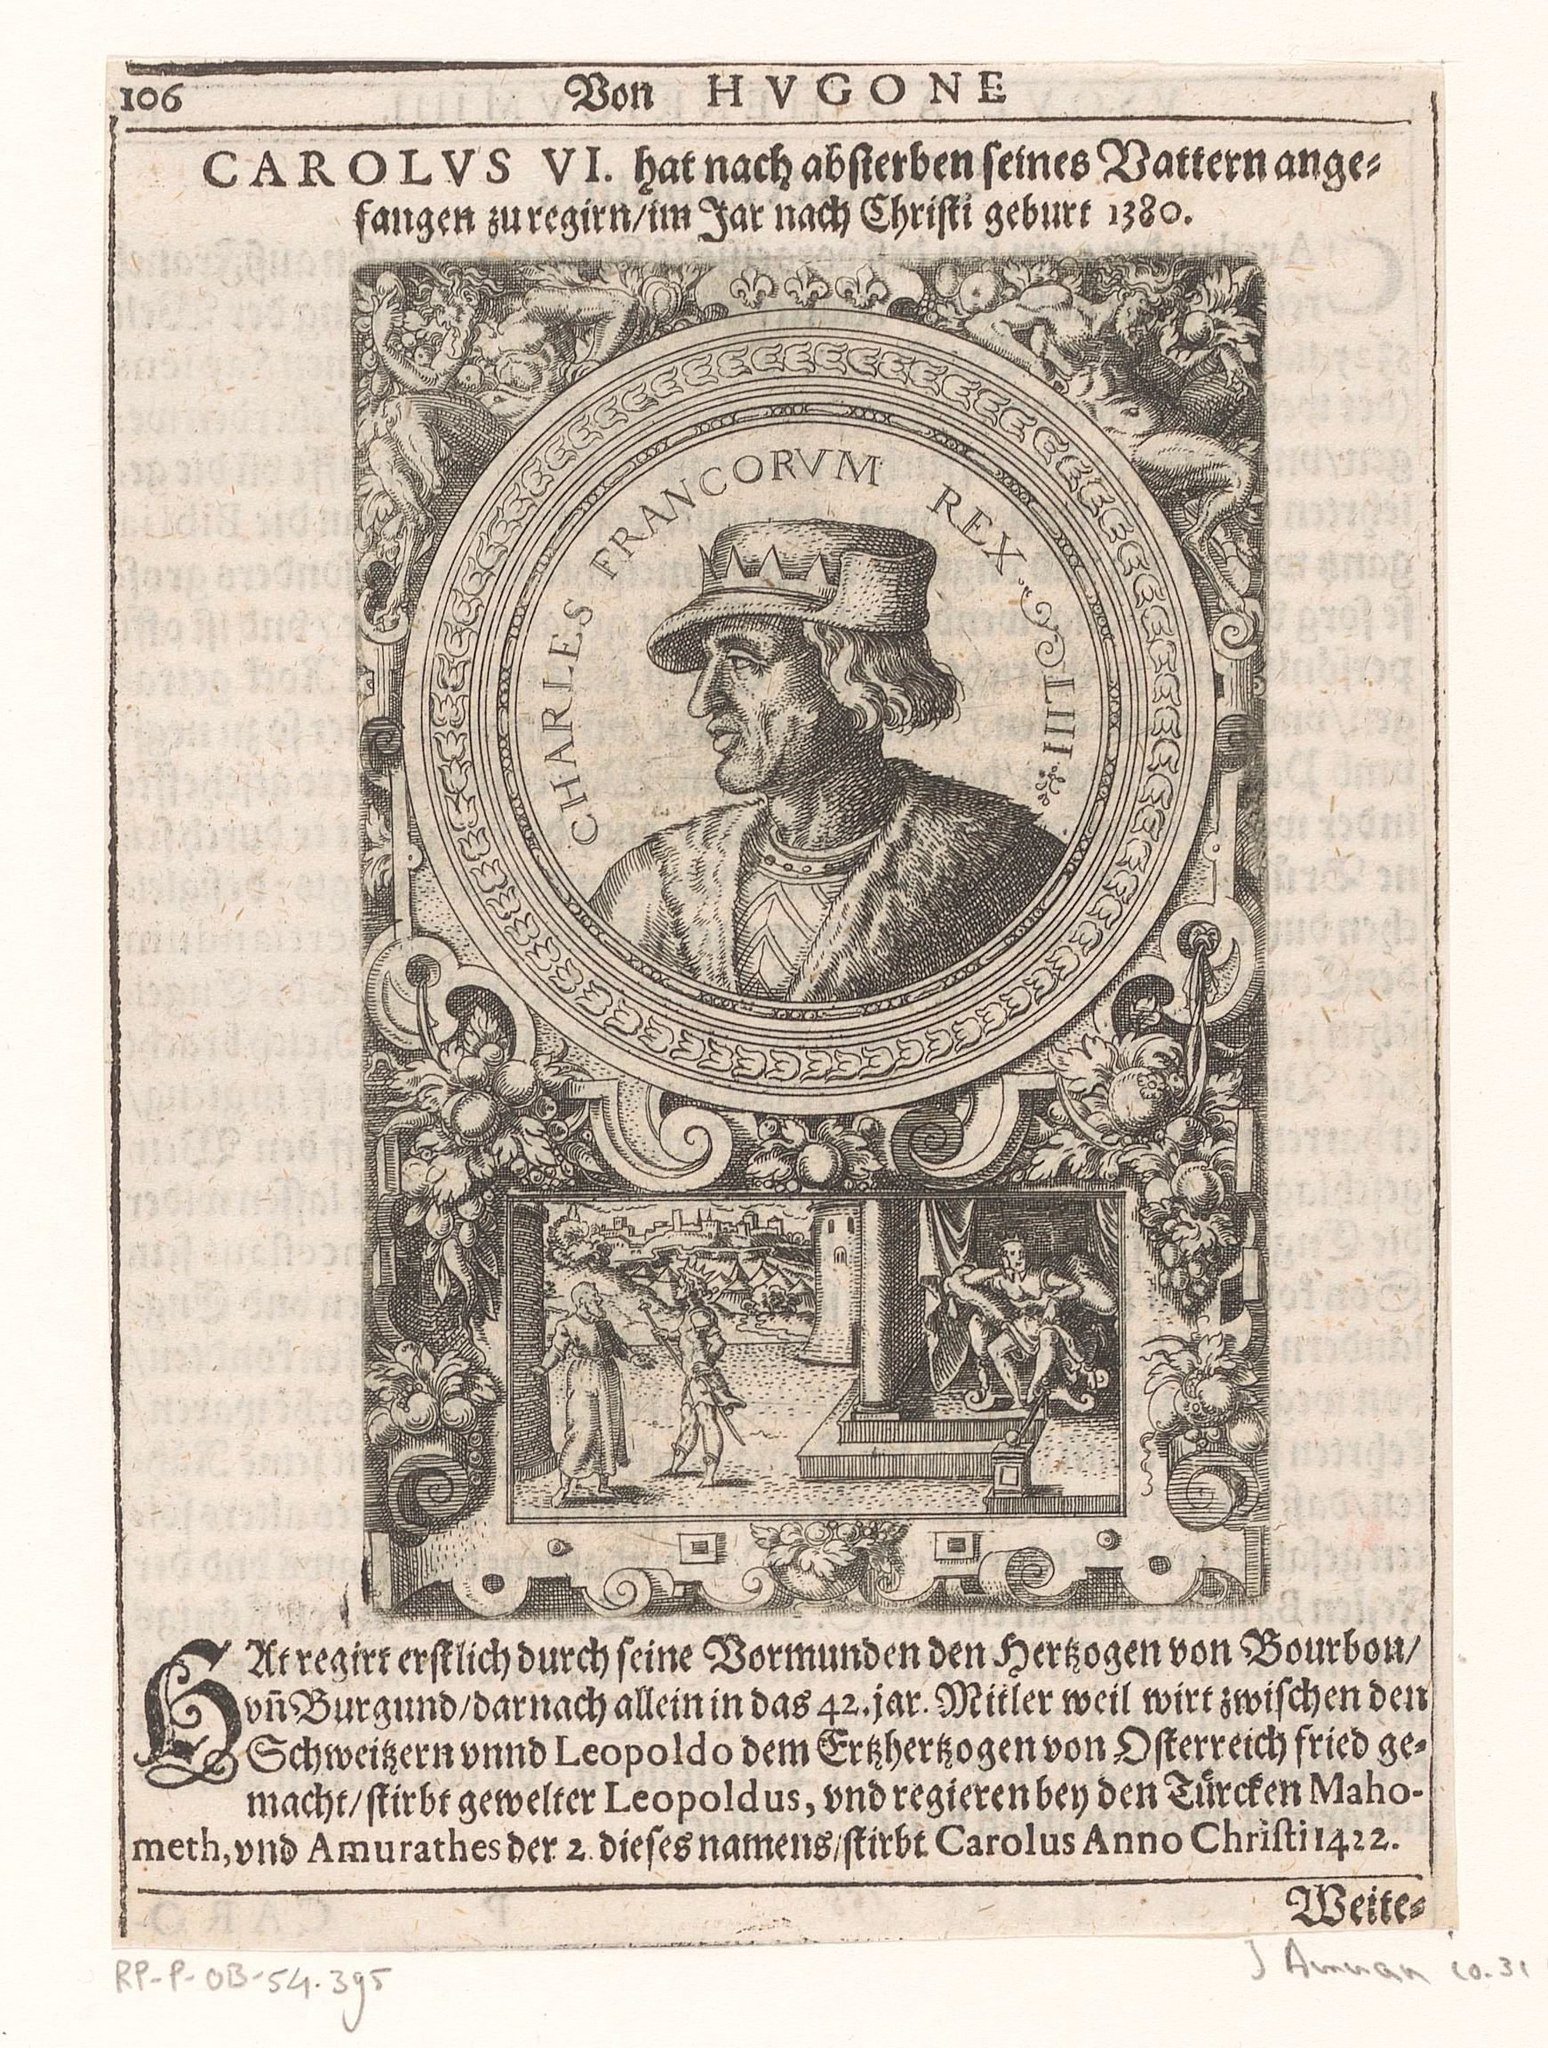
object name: book illustration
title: Portret van Karel VI, koning van Frankrijk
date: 1598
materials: paper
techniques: etching, intaglio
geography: nuremberg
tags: paris, scrollwork, strapwork ~ ornament, historical persons, ruler, sovereign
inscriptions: number: ‘158’, collector's mark: Lugt 2228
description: Prent afkomstig uit de publicatie: Michael Eizinger. Könige in Frankreich. Keulen: Johann Bussemacher, 1598, p. 106. De publicatie bevat prenten van Jost Amman en Virgil Solis.